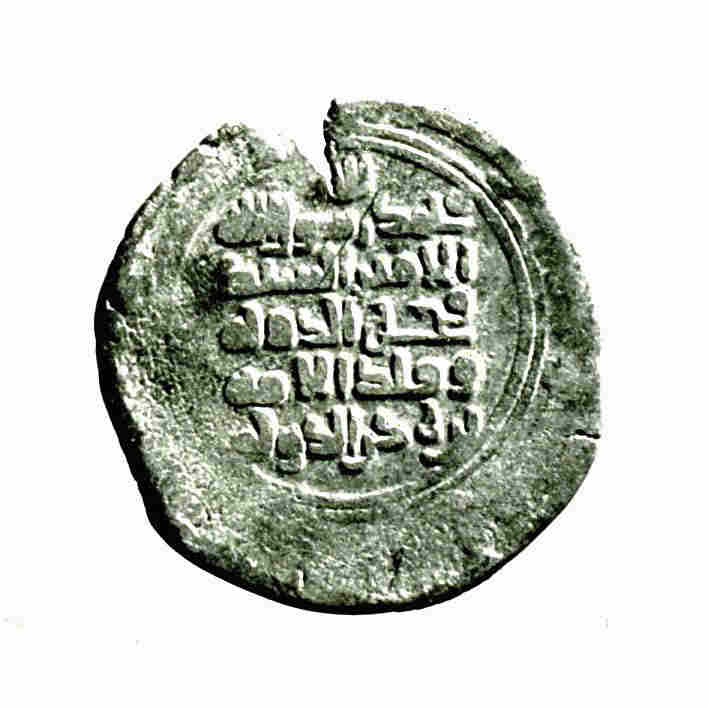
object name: coin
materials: silver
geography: iran